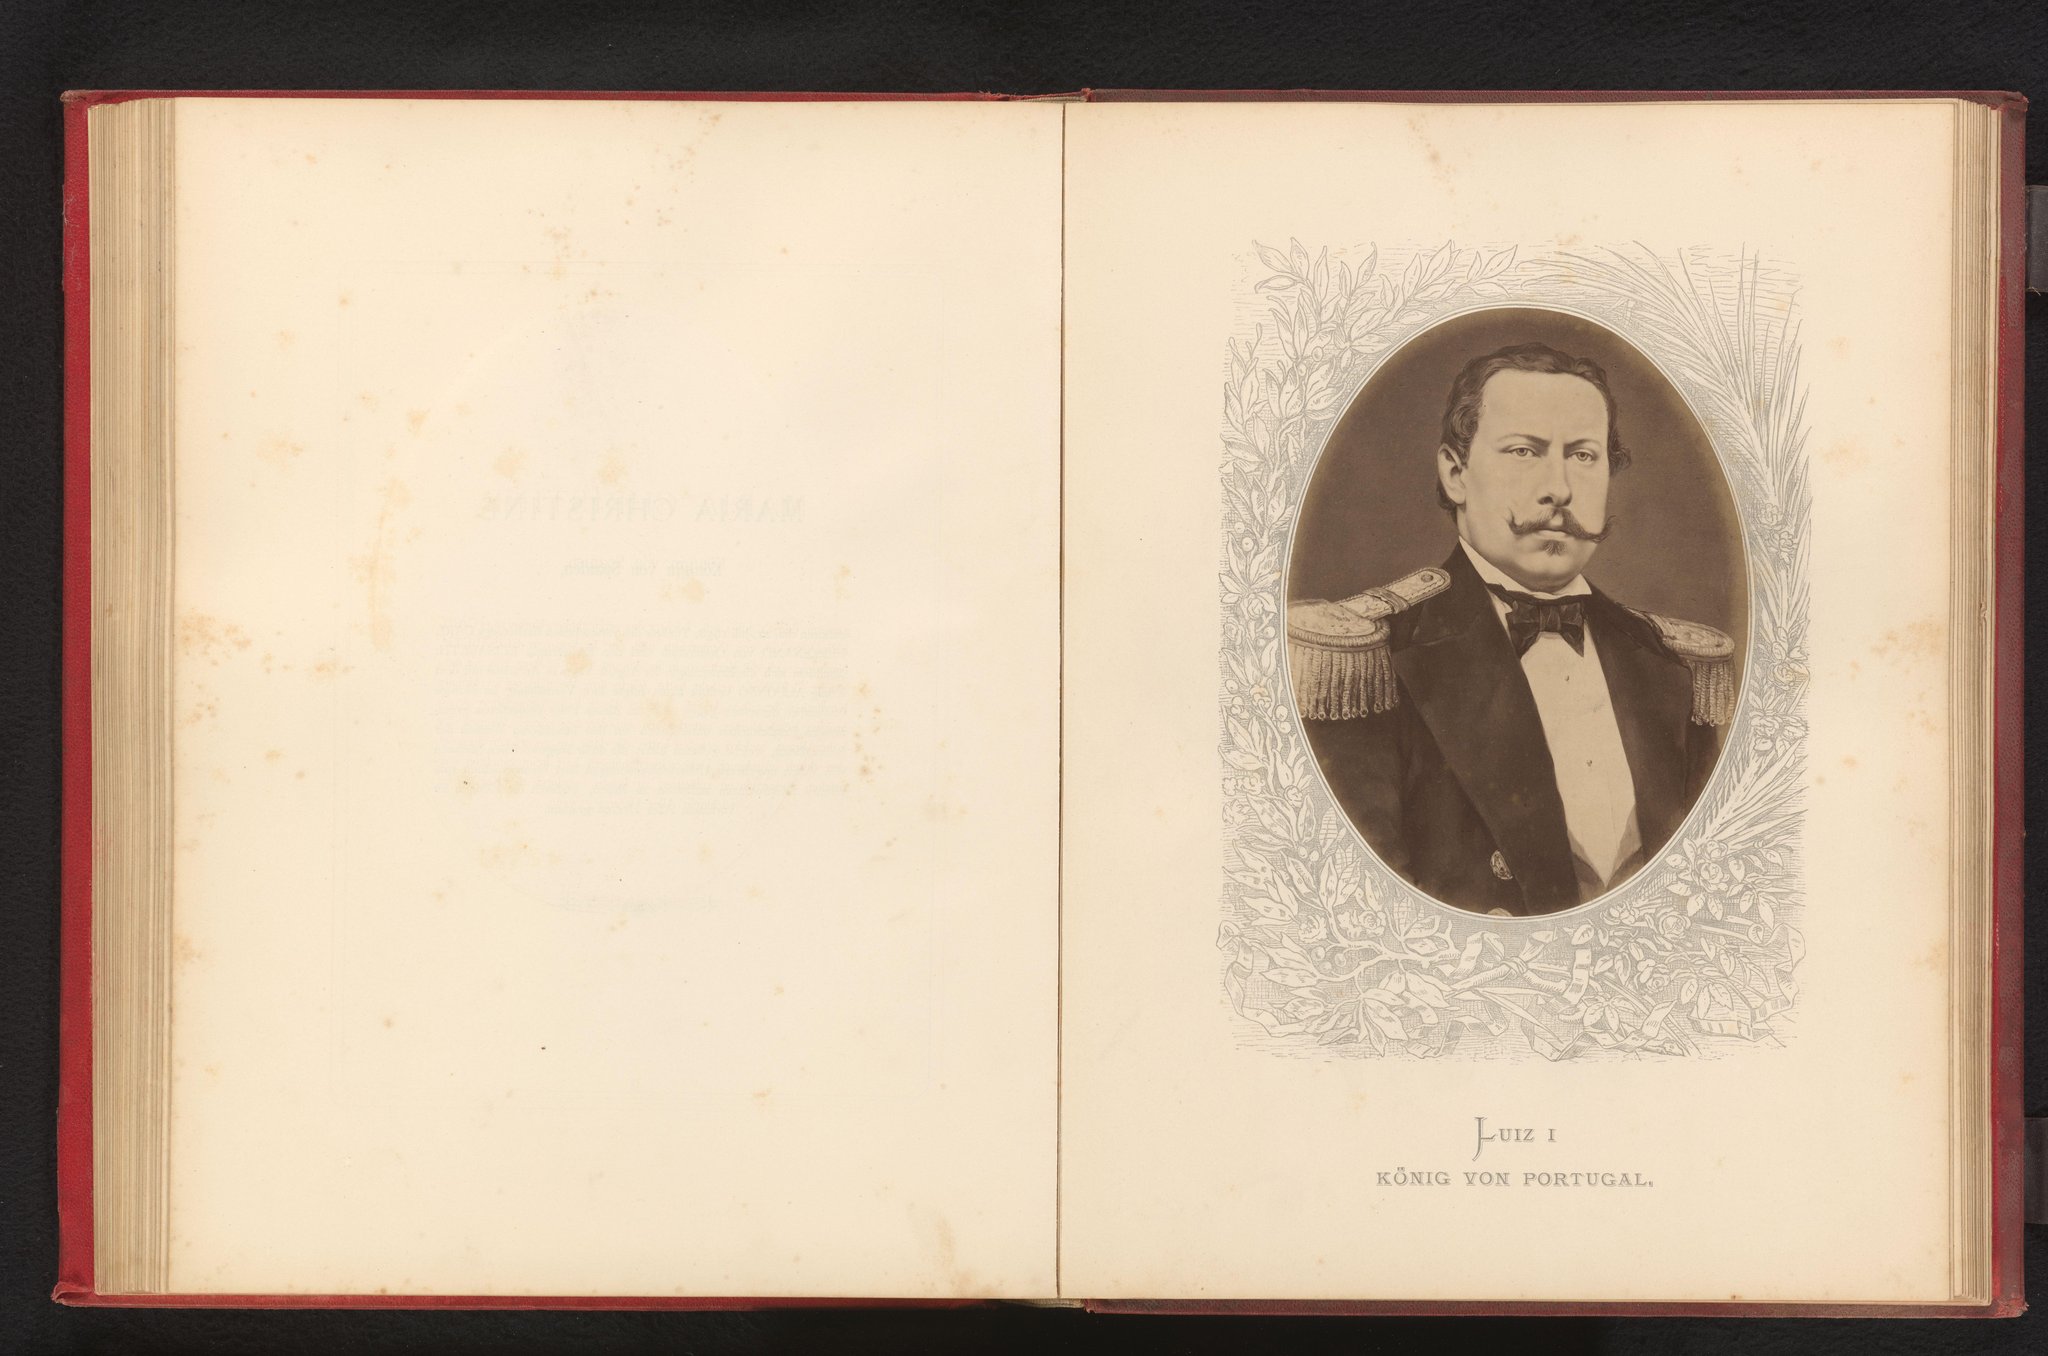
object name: reproduction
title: Luiz I, König von Portugal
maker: Anonymous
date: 1875-1880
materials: cardboard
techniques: albumen print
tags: historical persons, king